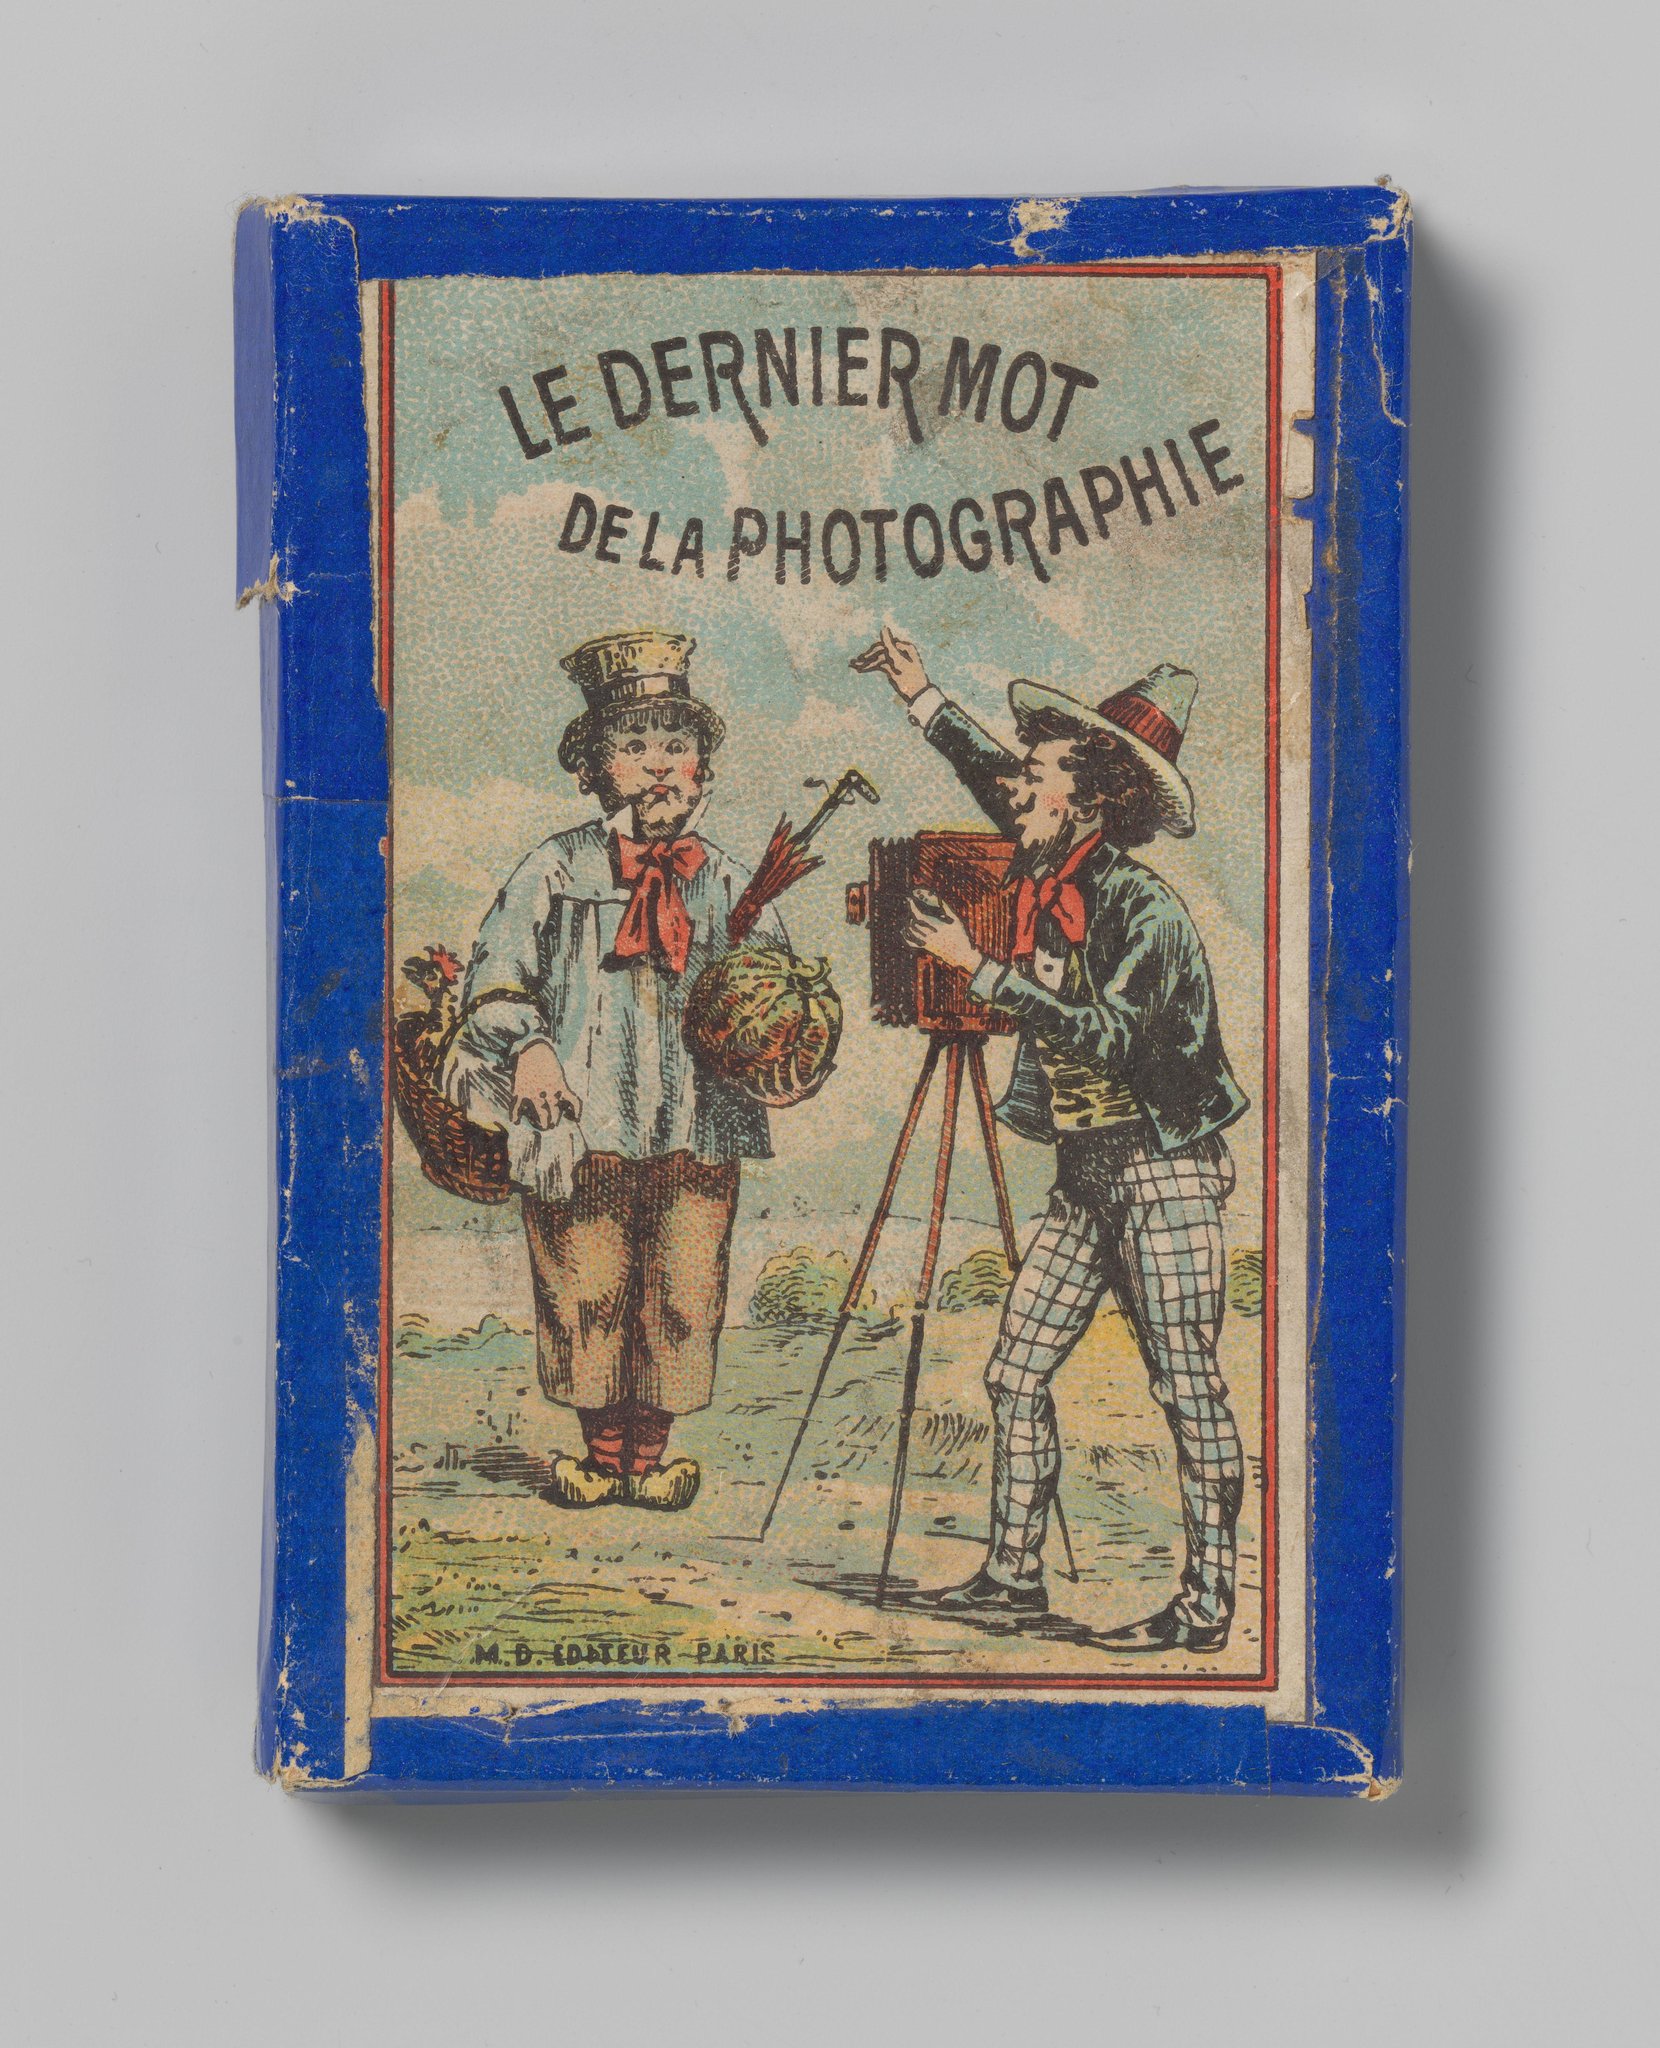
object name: photograph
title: Doosje met zogenaamde zelfmaakfoto 'Le Dernier Mot de la Photographie'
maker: m.d.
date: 1860-1880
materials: cardboard, paper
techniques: lithograph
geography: france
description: Doosje met zogenaamde zelfmaakfoto 'Le Dernier Mot de la Photographie'; als men aan het lipje trekt komt er een beeltenis van een aap tevoorschijn